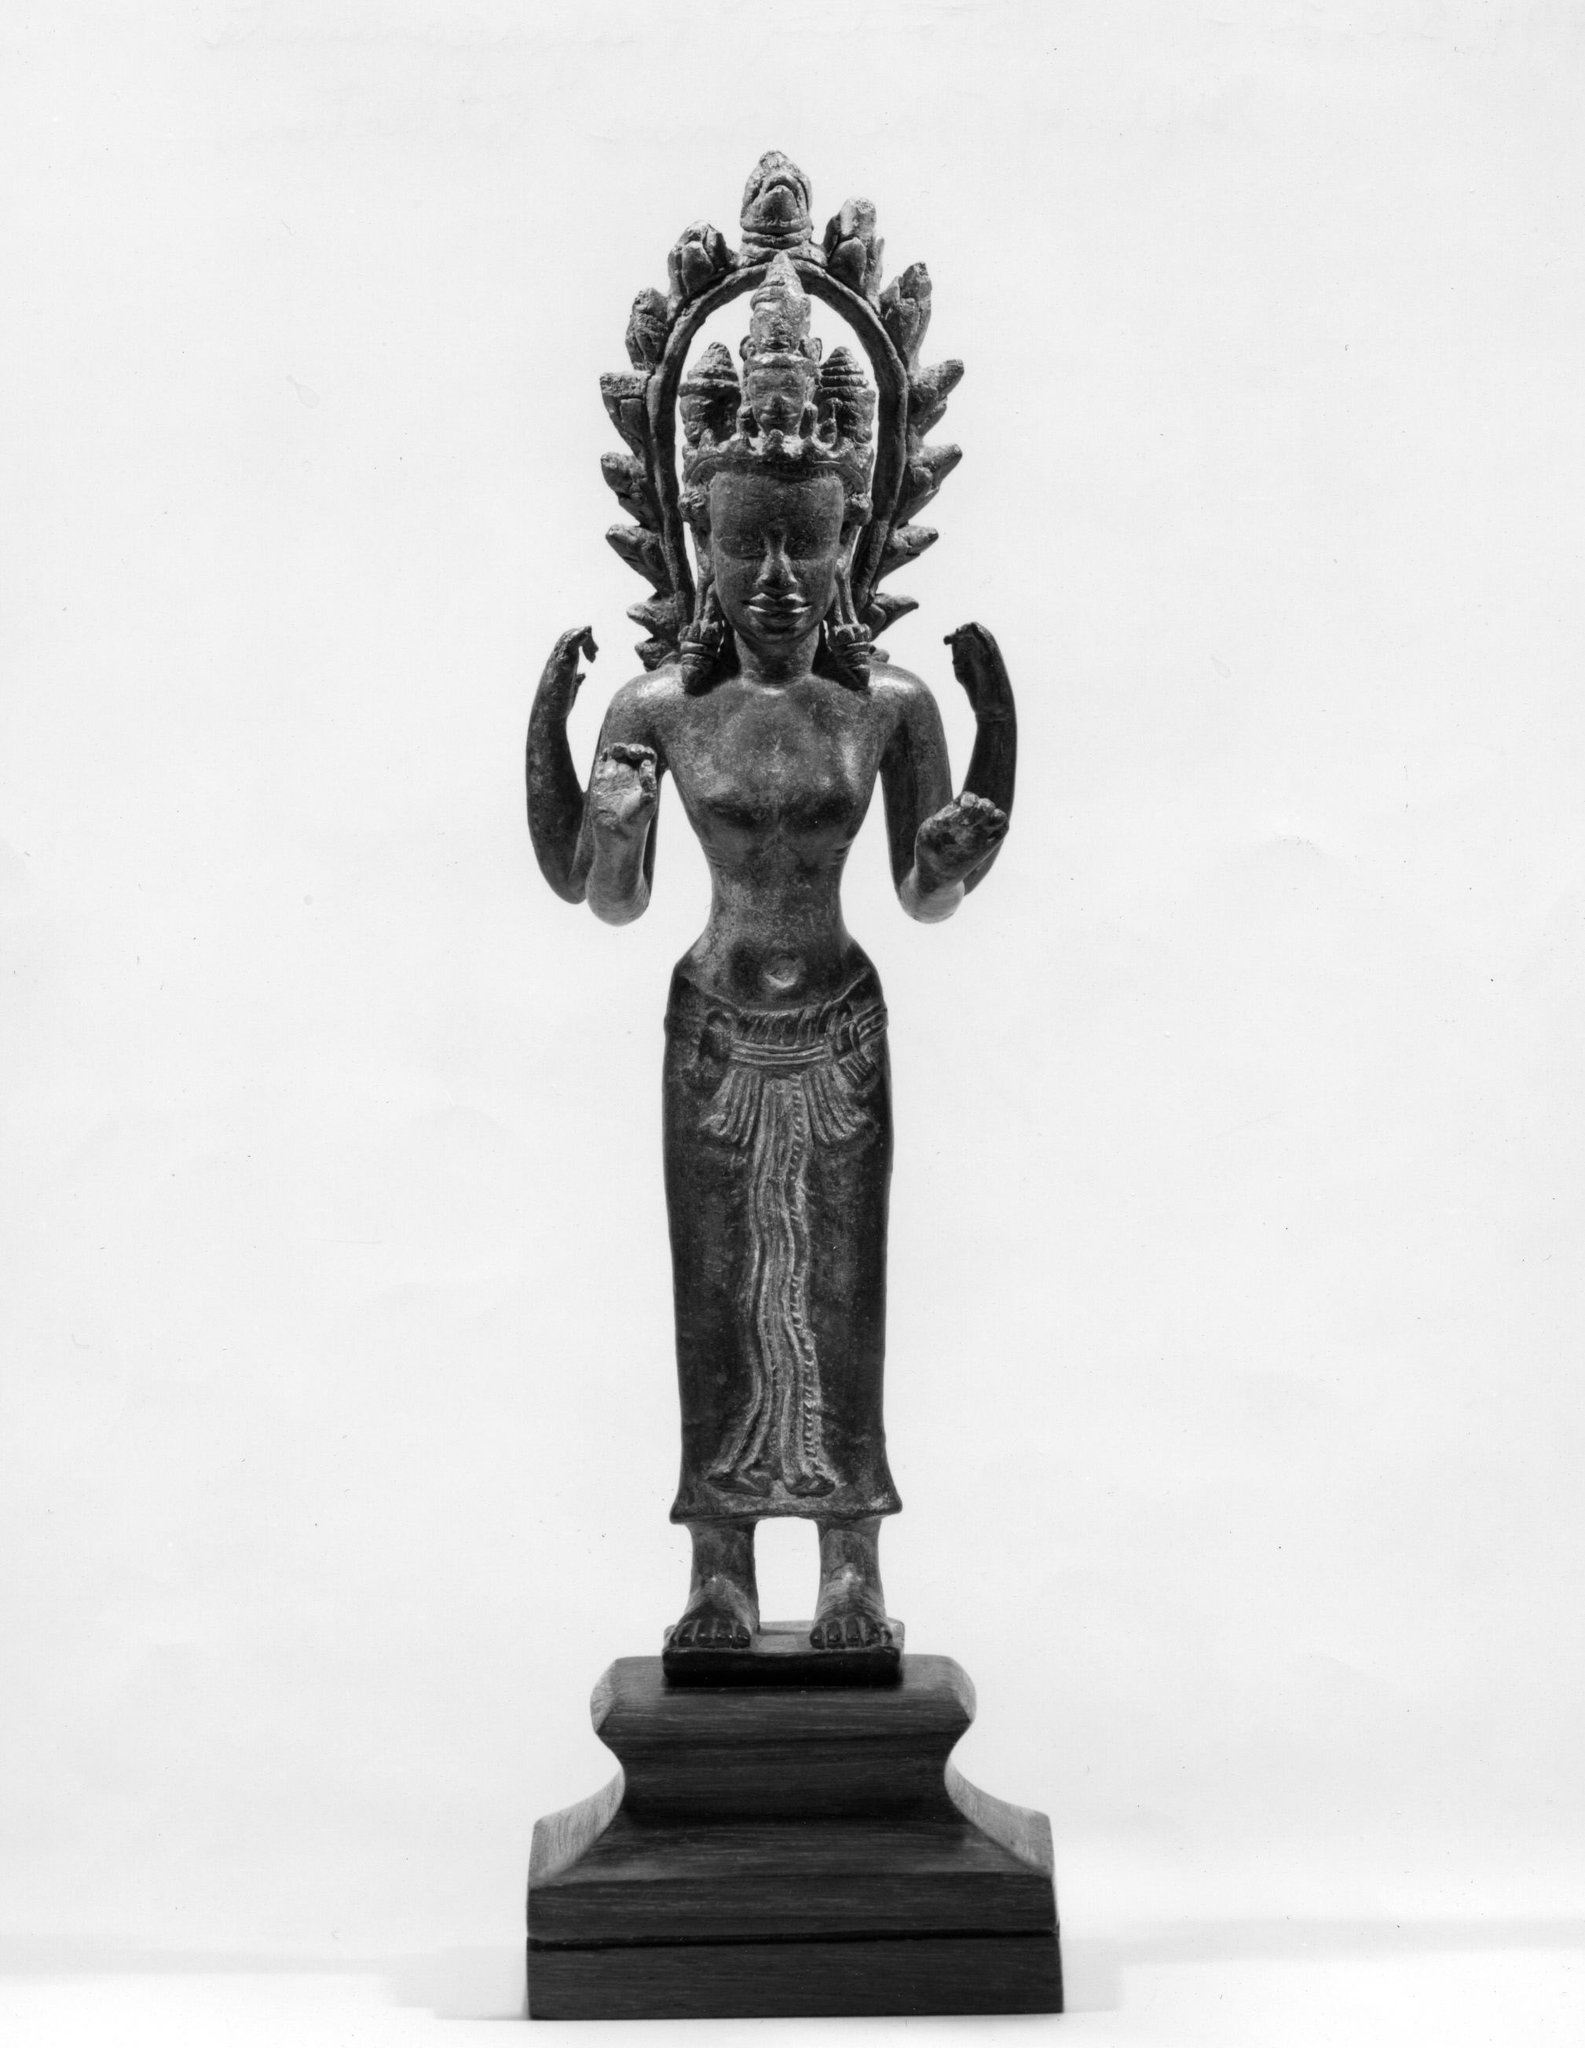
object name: figure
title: Standing Prajnaparamita, the Goddess of Transcendent Wisdom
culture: thai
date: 1001-1100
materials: bronze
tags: goddess